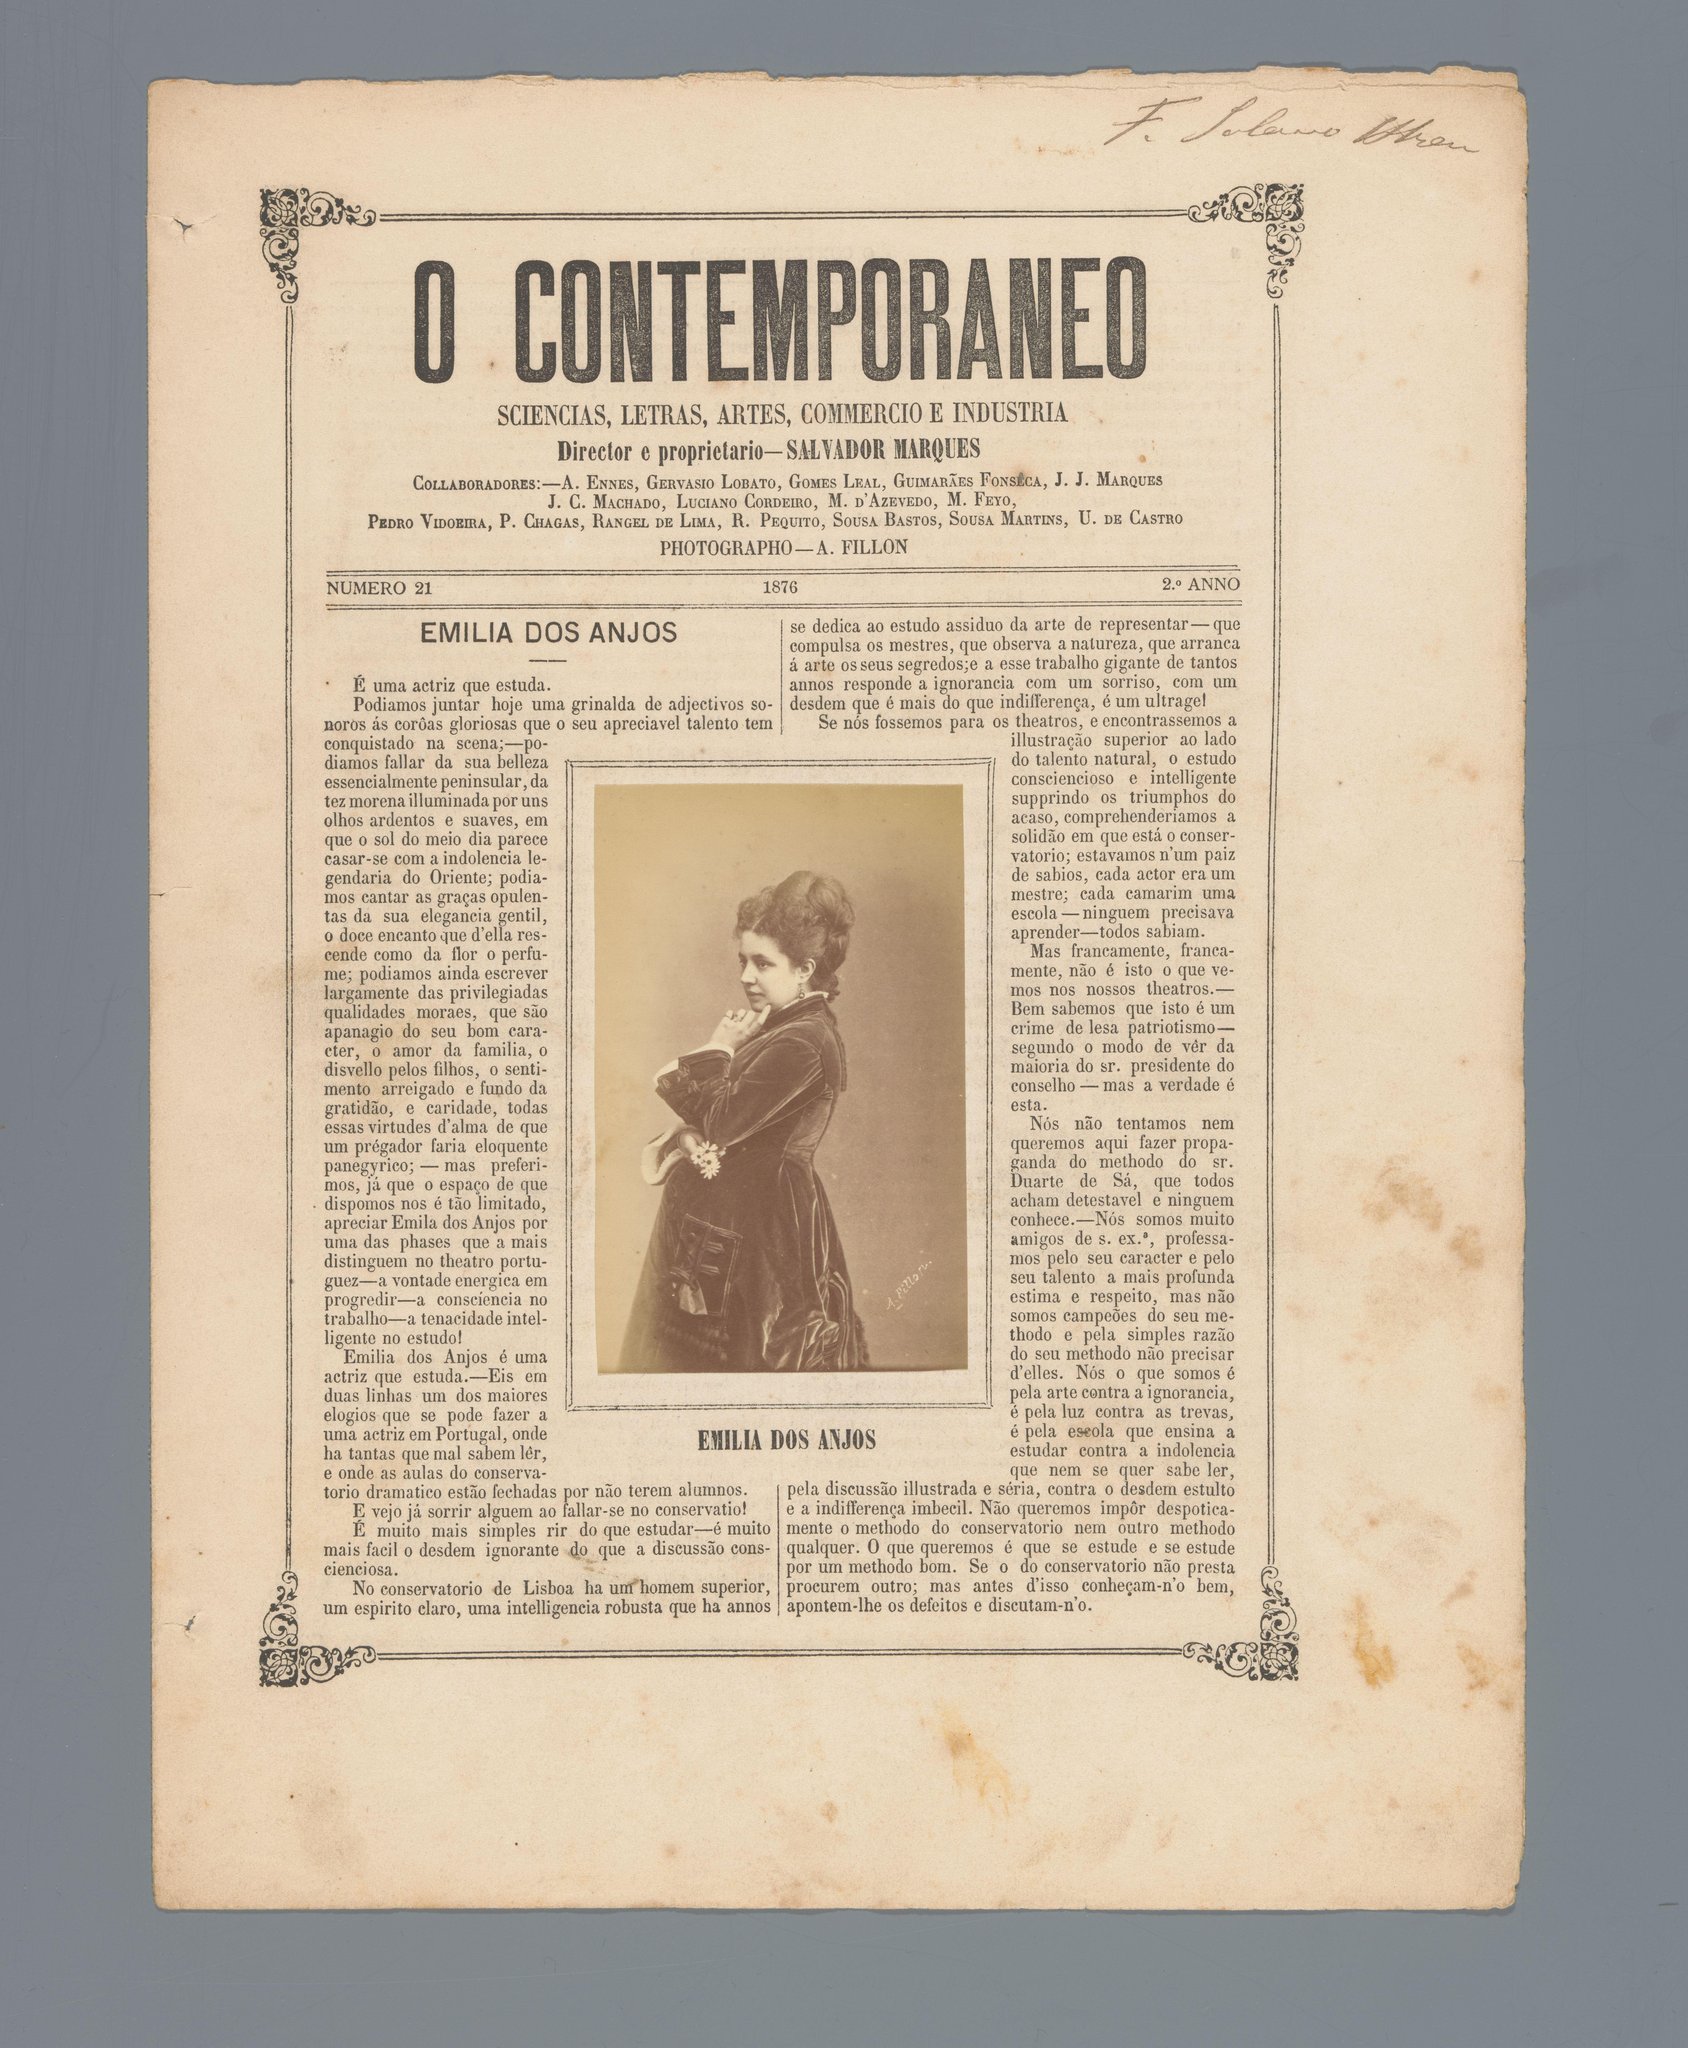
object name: magazine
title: O contemporaneo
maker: alfred fillon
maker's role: fotograaf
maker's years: 1825-1881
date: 1871-1876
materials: paper, photographic support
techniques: albumen print, printing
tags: historical persons - bb - woman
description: Op de voorpagina bevindt zich een portret van Emilia dos Anjos.